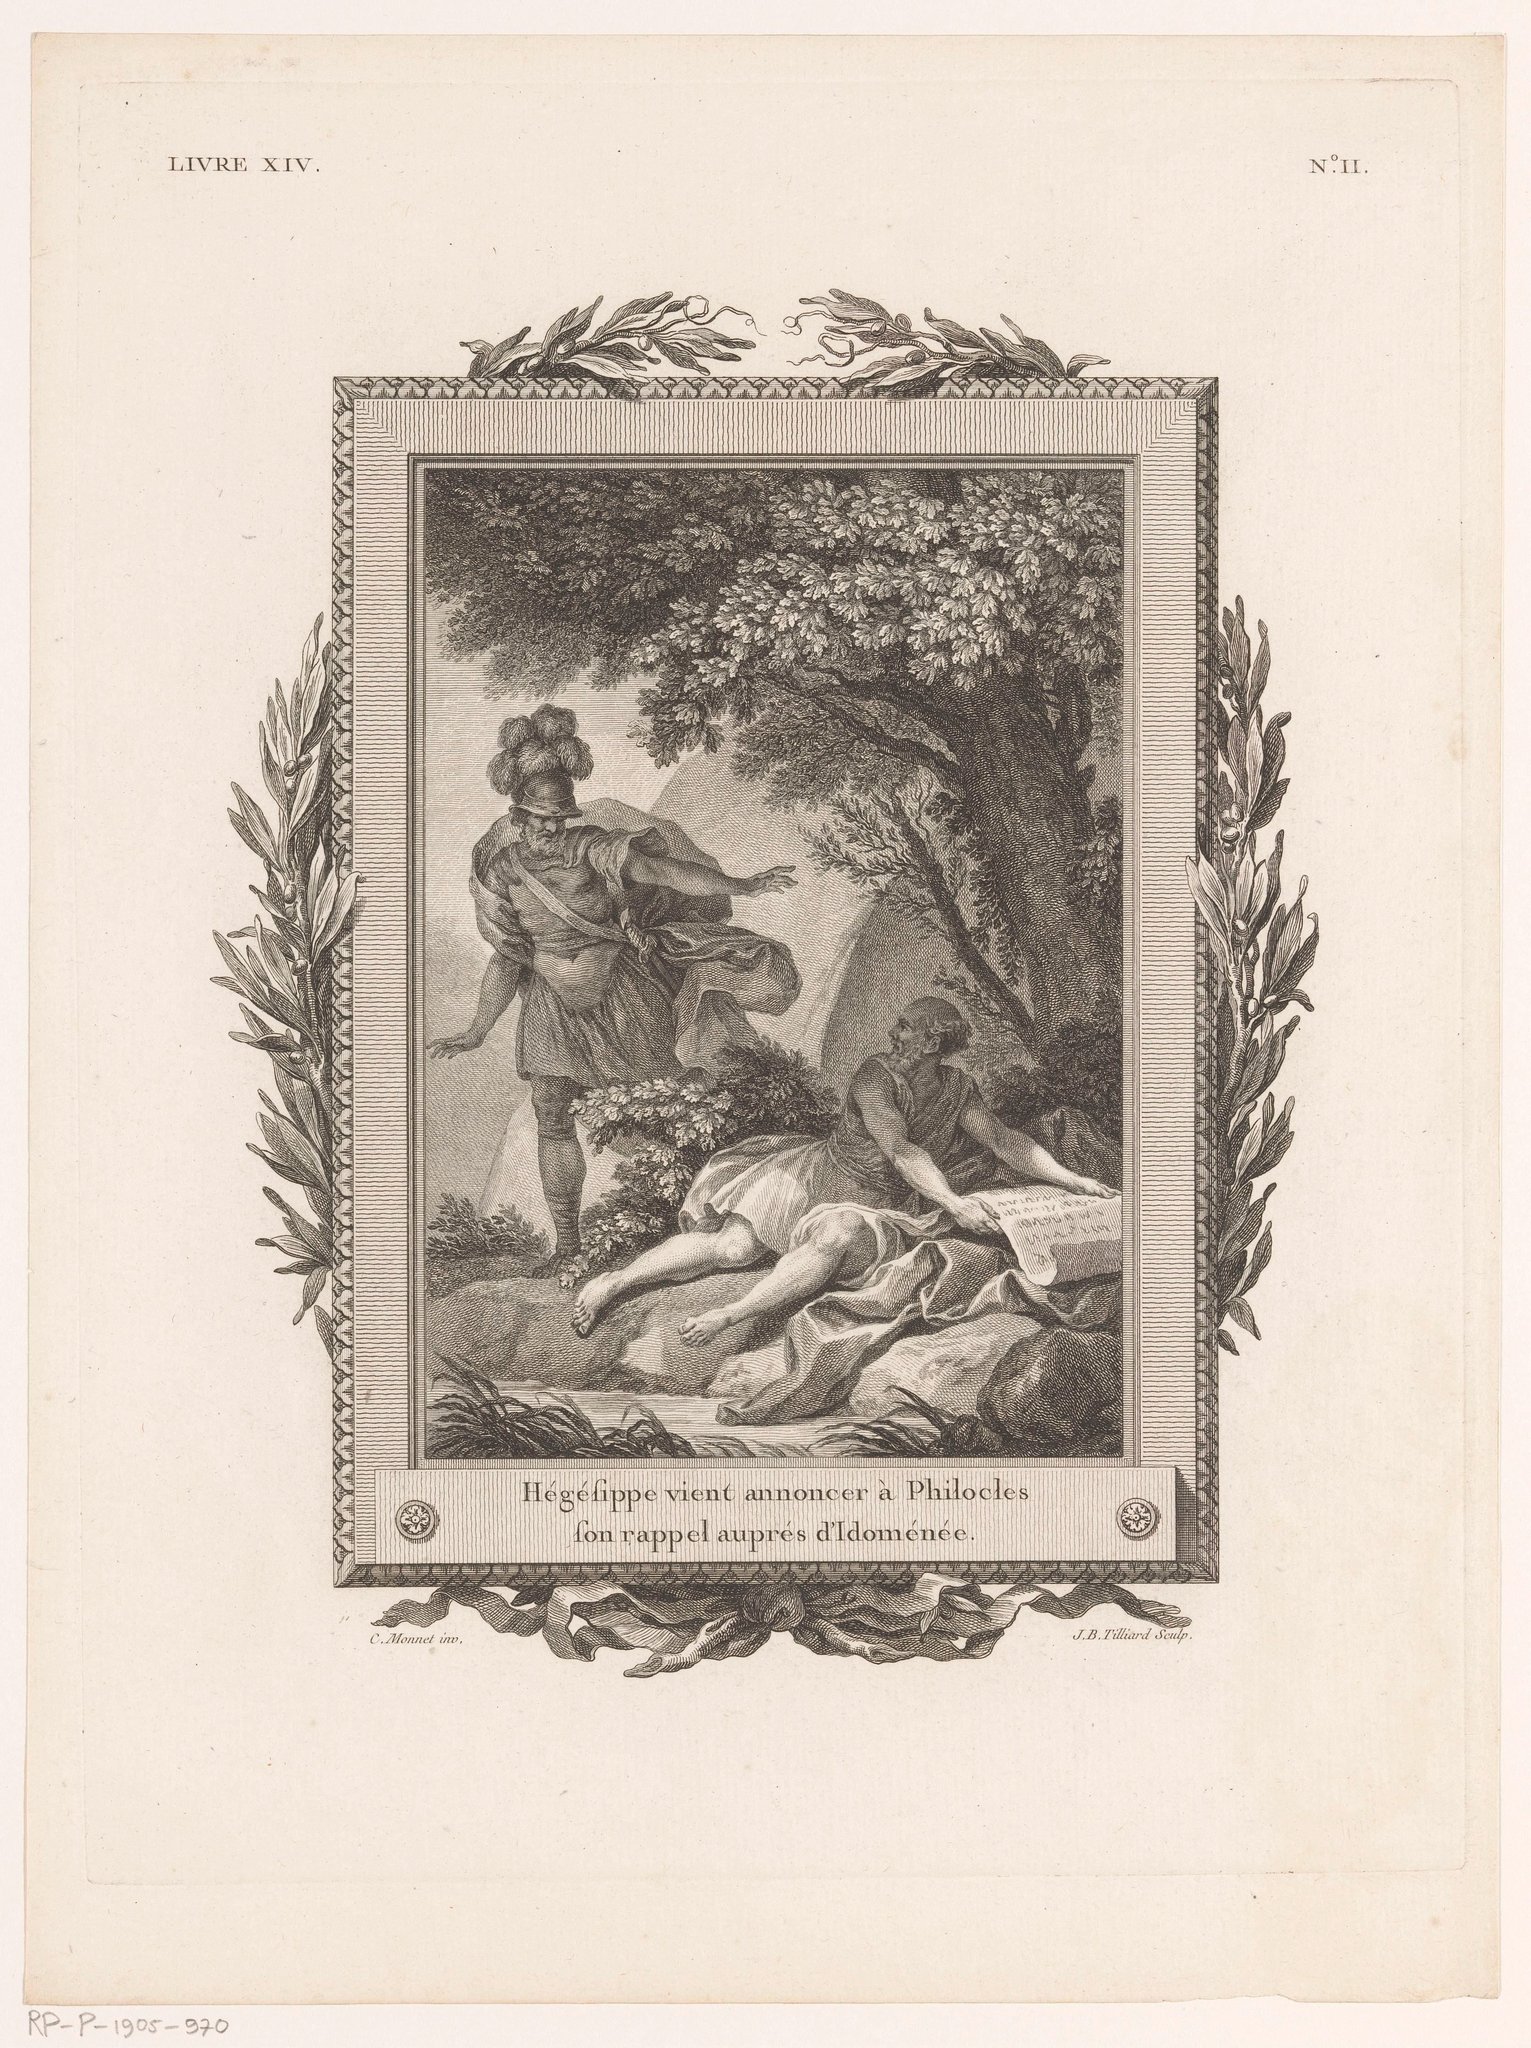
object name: print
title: Hegesippus ontbiedt Philokles terug te komen op verzoek van Idomeneus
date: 1785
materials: paper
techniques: engraving, etching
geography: paris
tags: (fenelon, telemachus) specific works of literature (with author, title), ornament ~ festoon, garland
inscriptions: collector's mark: Lugt 2228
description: Idomeneus, zittend op een steen onder een boom, leest een brief. Links van hem staat Hegesippus. Het geheel wordt gekaderd door een sierlijst met olijftakken en onderaan een strik. Genummerd rechtsboven: No. II.